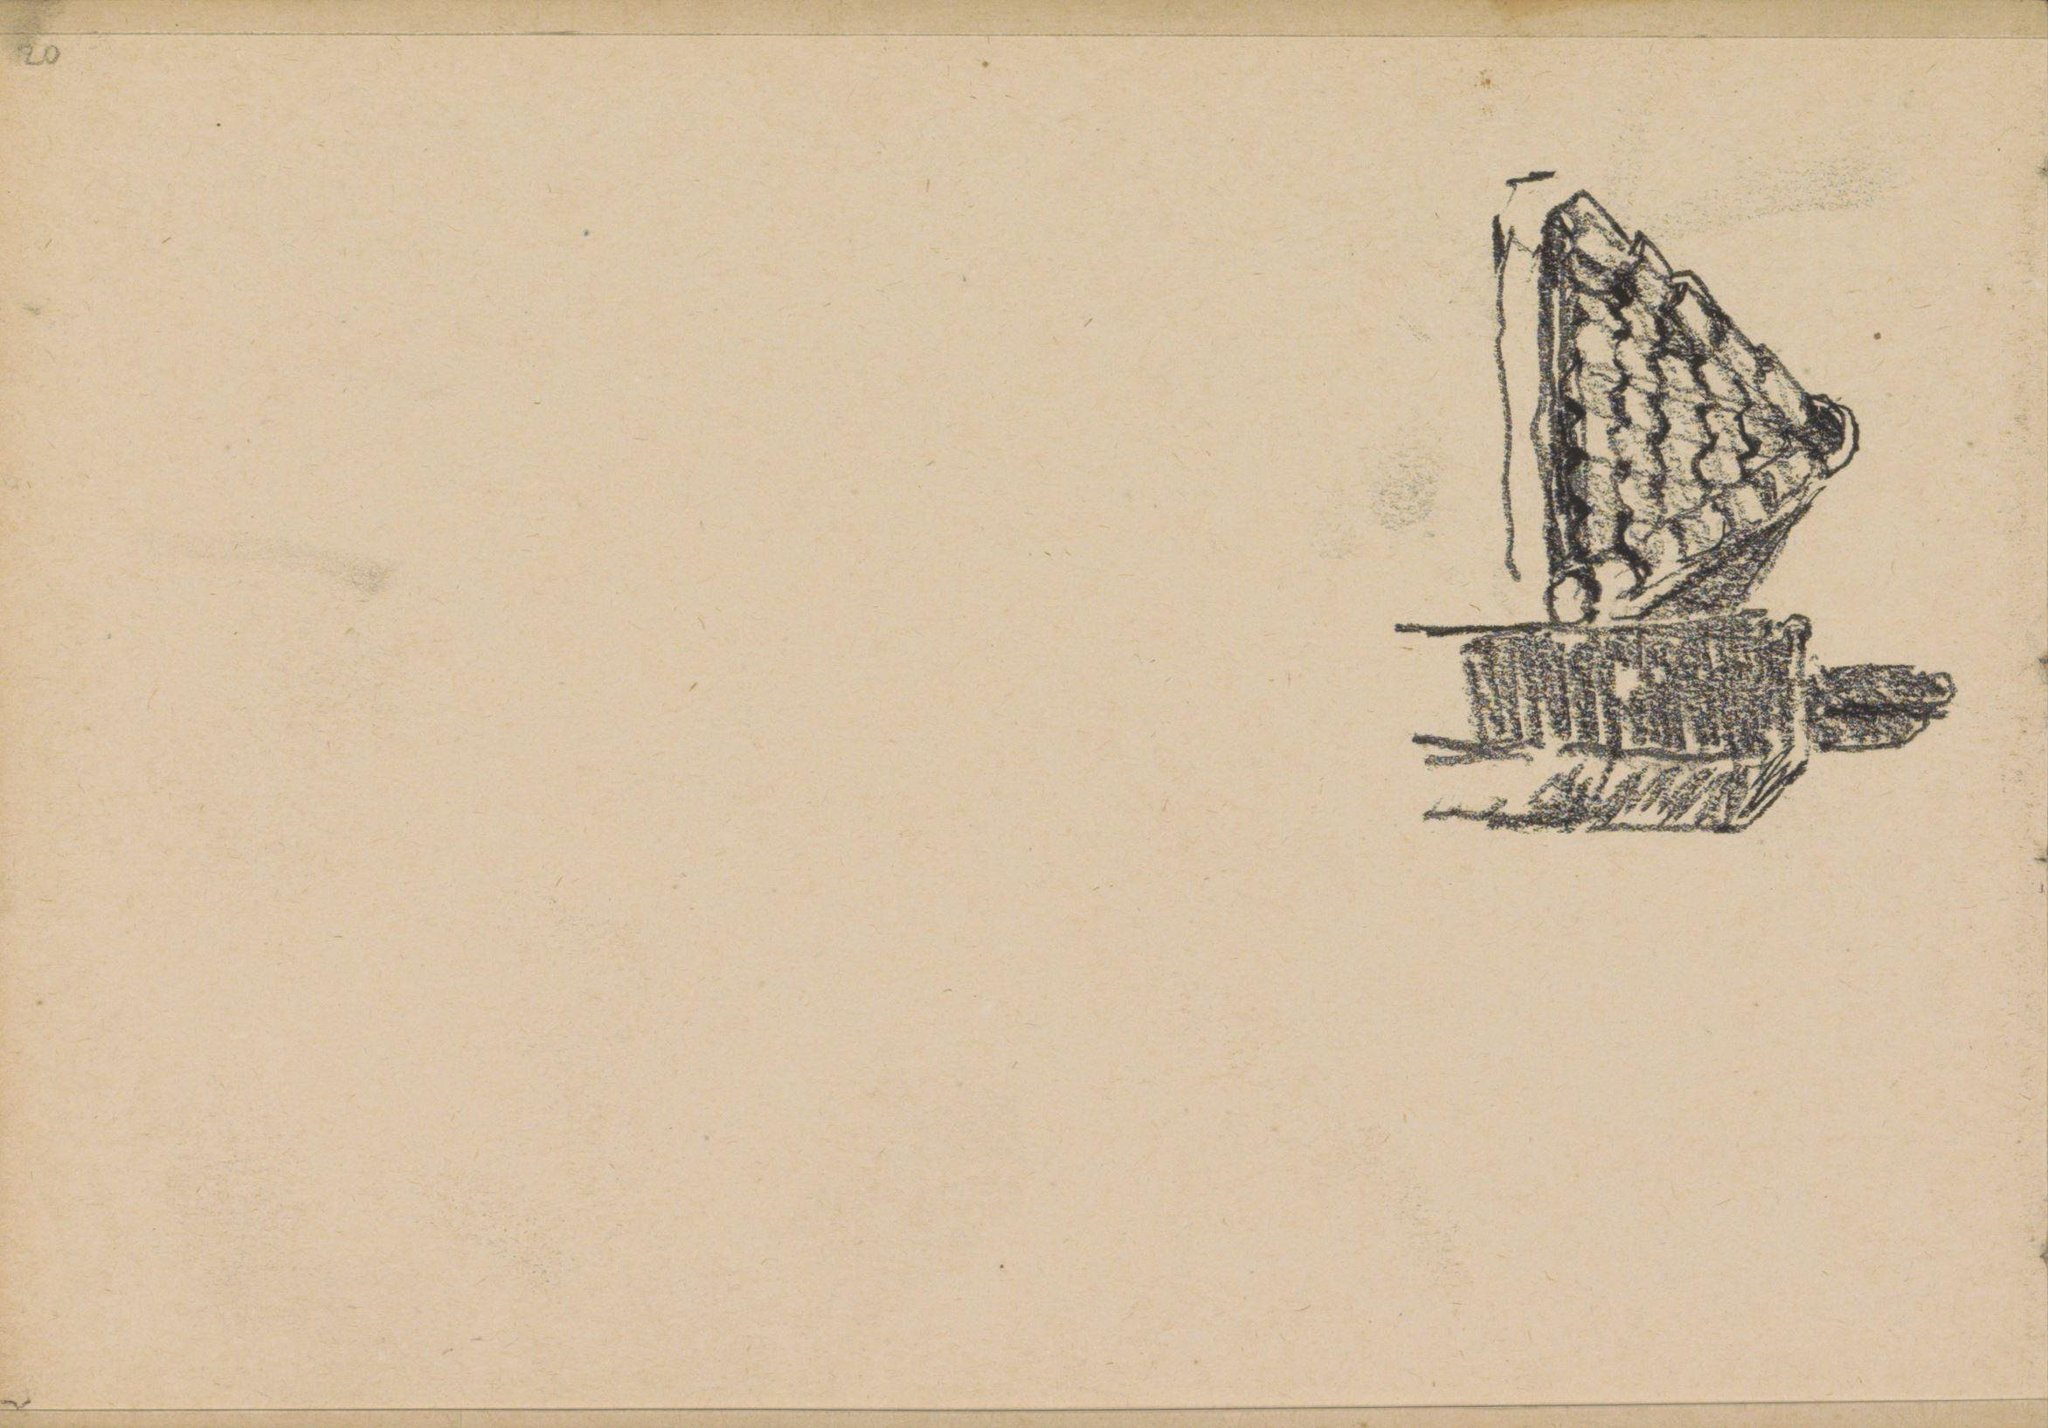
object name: sketchbook leaf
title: Dak met een schoorsteen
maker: willem witsen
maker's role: draughtsman, painter, print maker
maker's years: 1860-1923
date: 1906-1907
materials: paper, pencil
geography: wijk bij duurstede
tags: chimney, roof (of house or building)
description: Pagina 20 uit een schetsboek met 25 bladen.